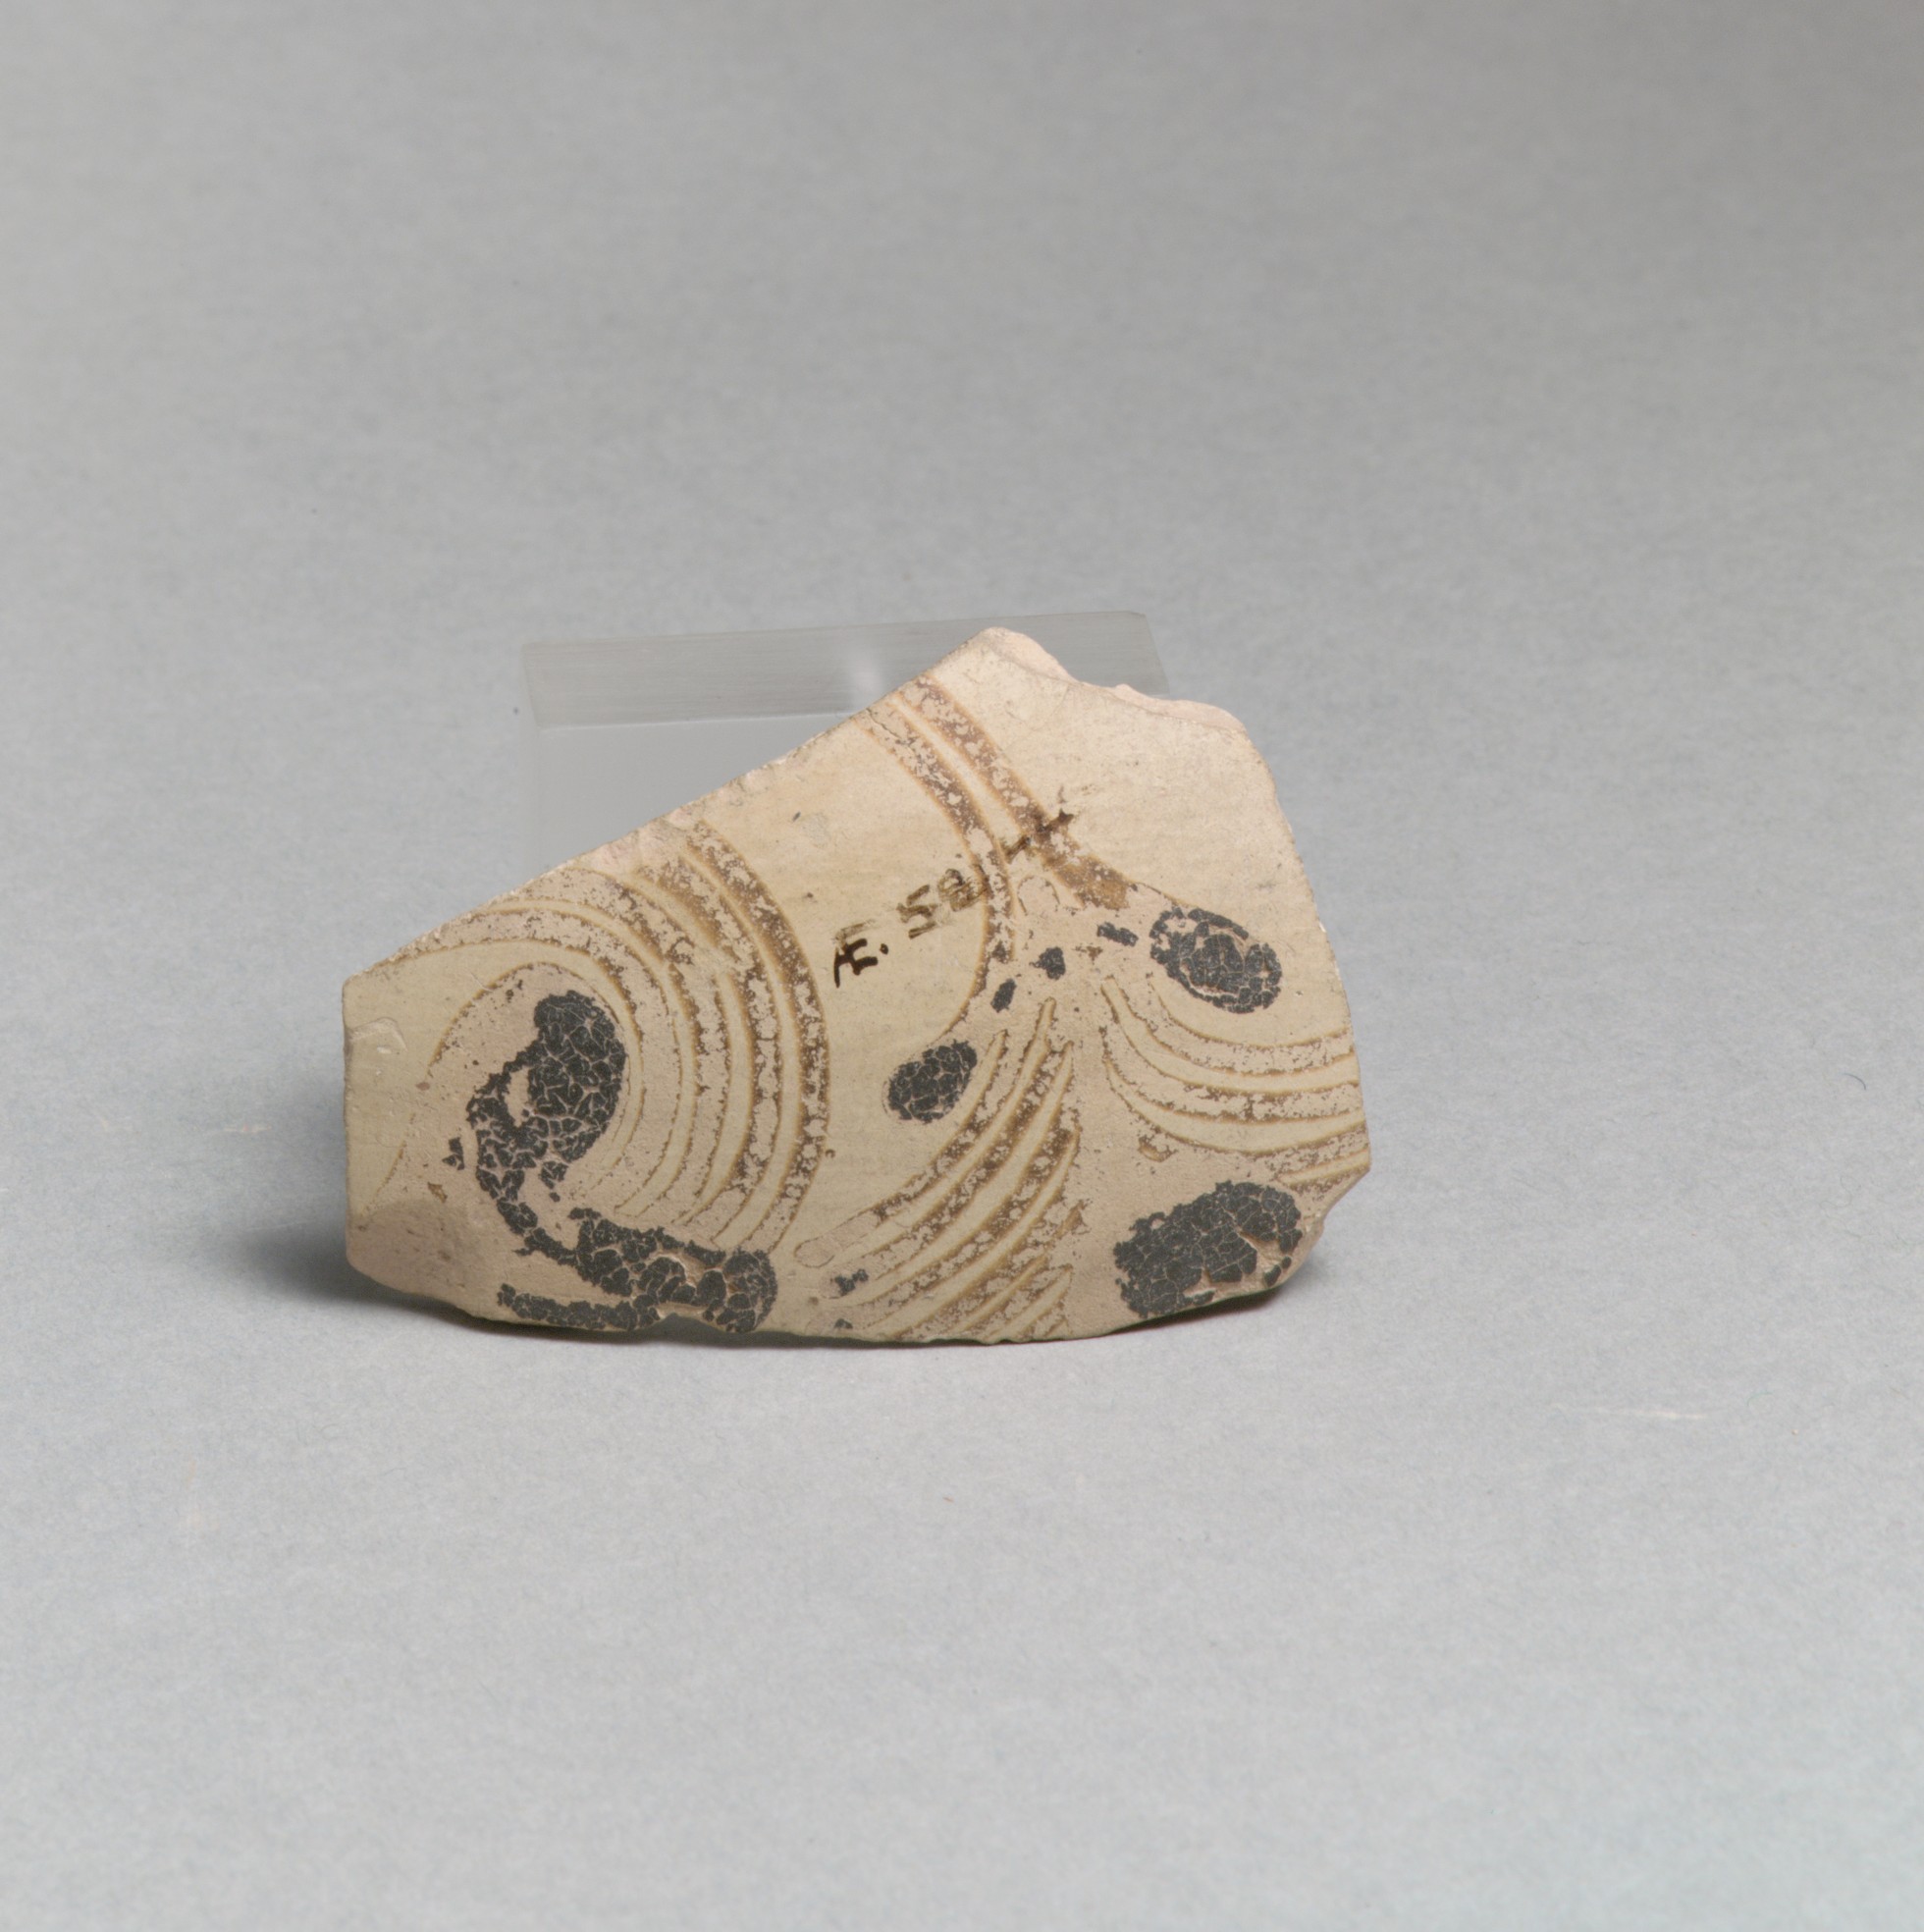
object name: vase fragment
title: Terracotta vessel fragment with floral design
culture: minoan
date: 1400-1200 BCE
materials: terracotta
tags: flowers